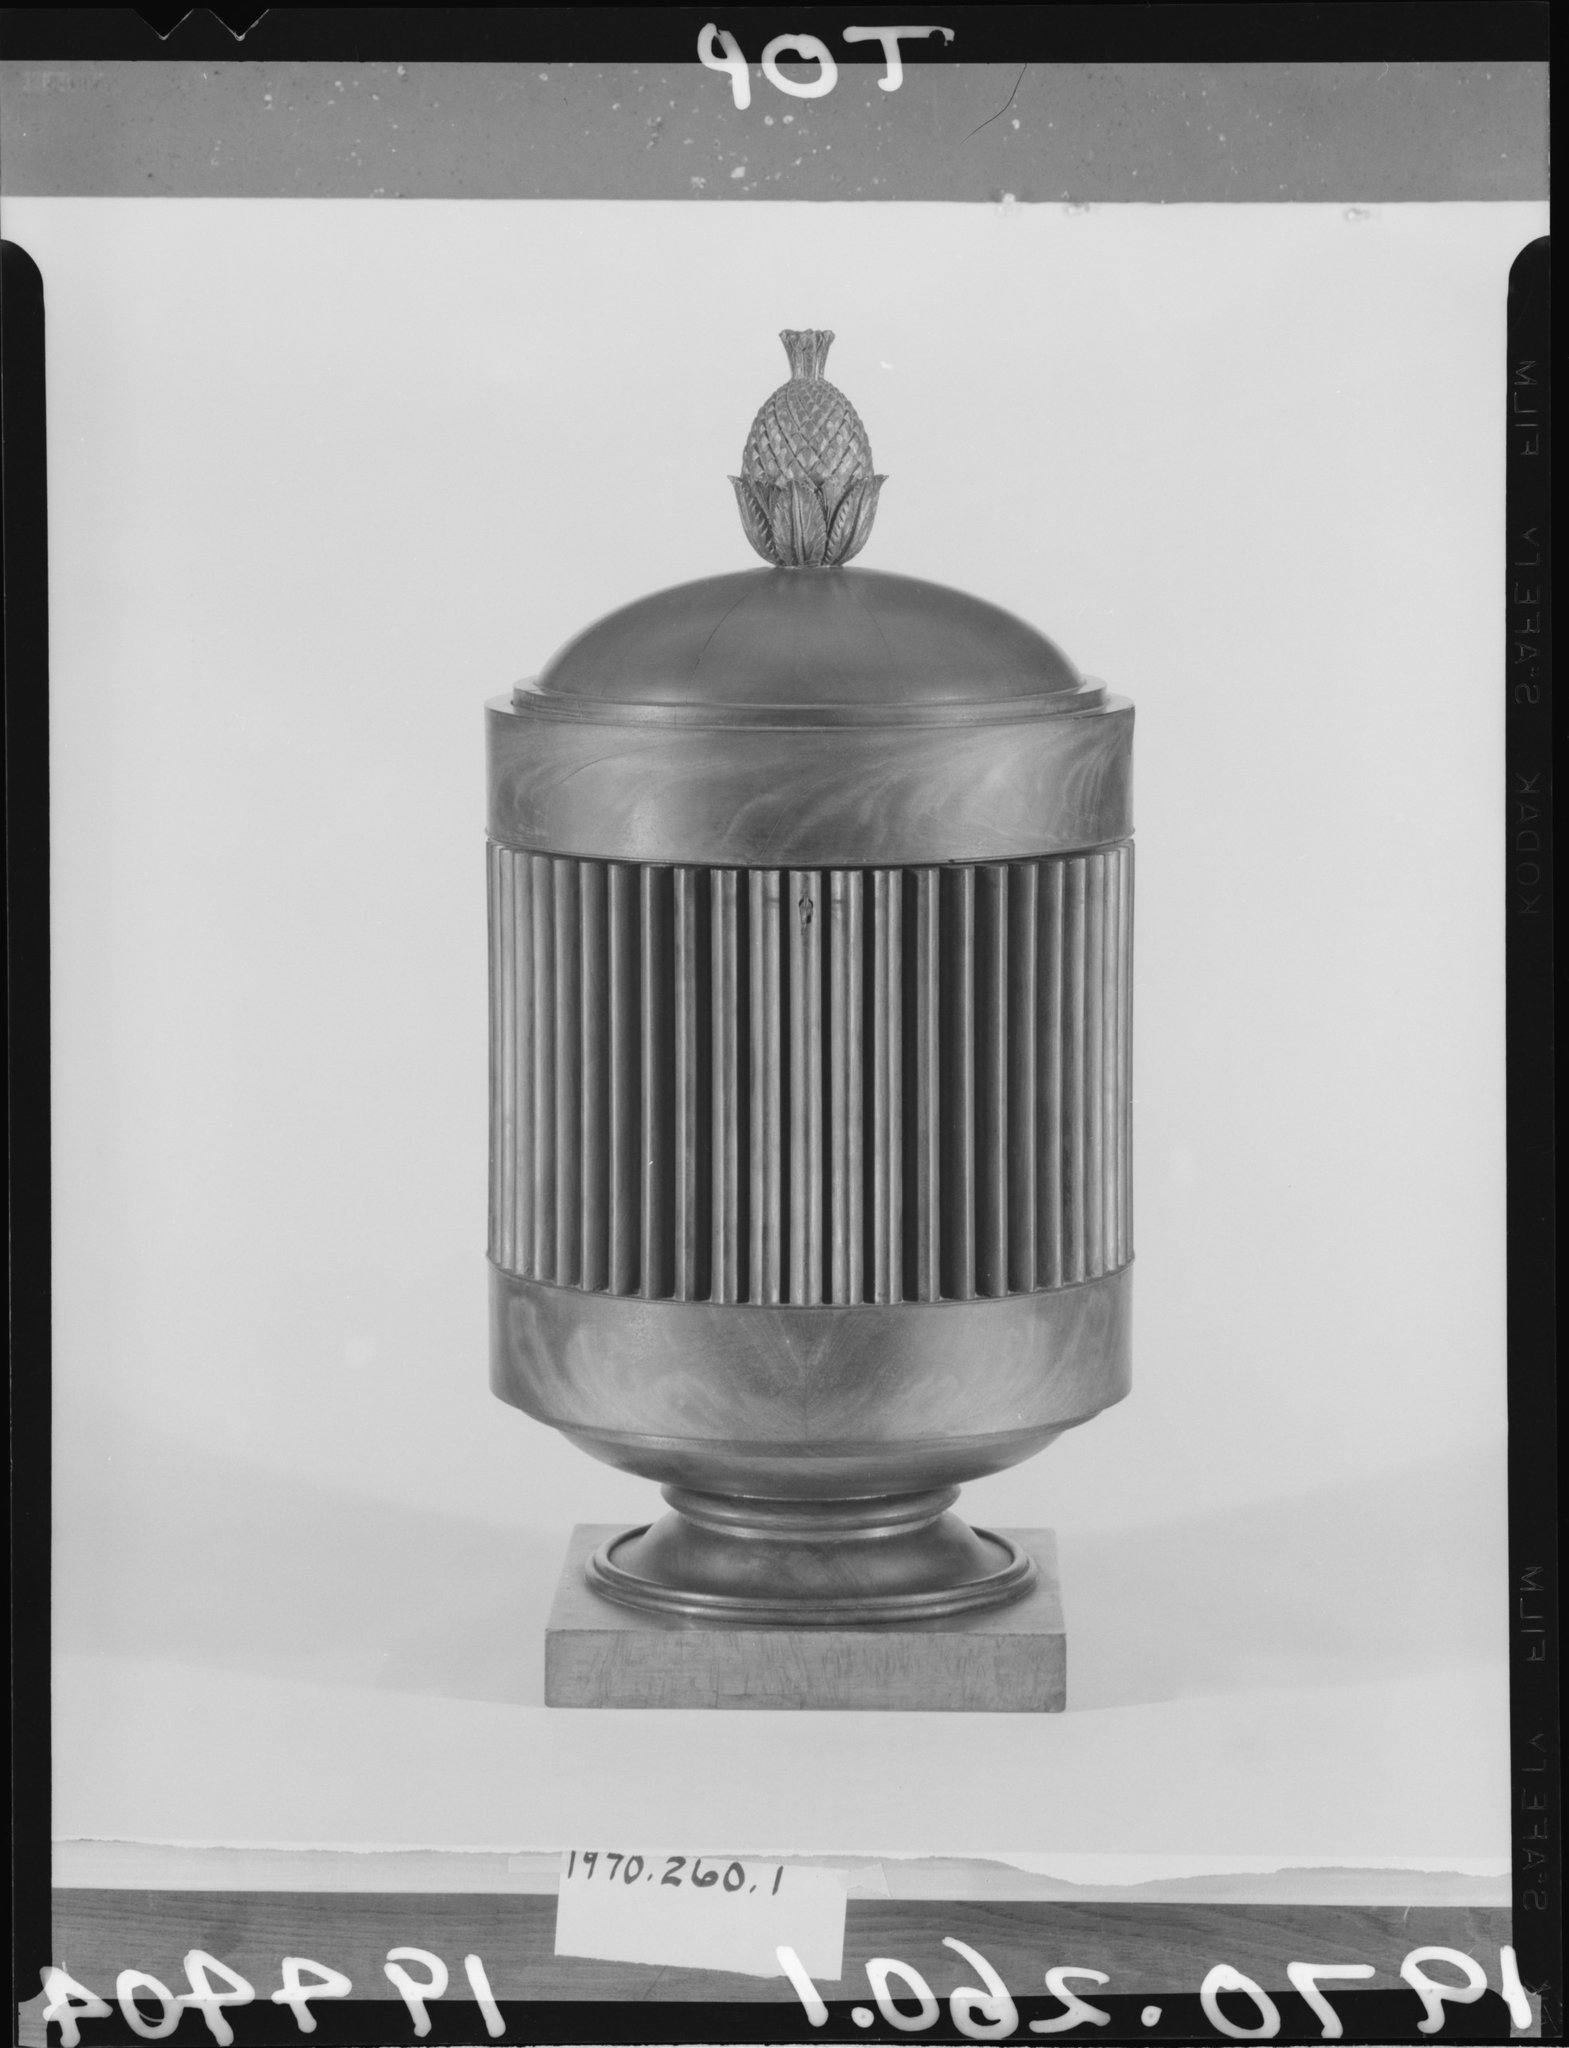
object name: knife urn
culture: american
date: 1820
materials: wood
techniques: veneering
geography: united states